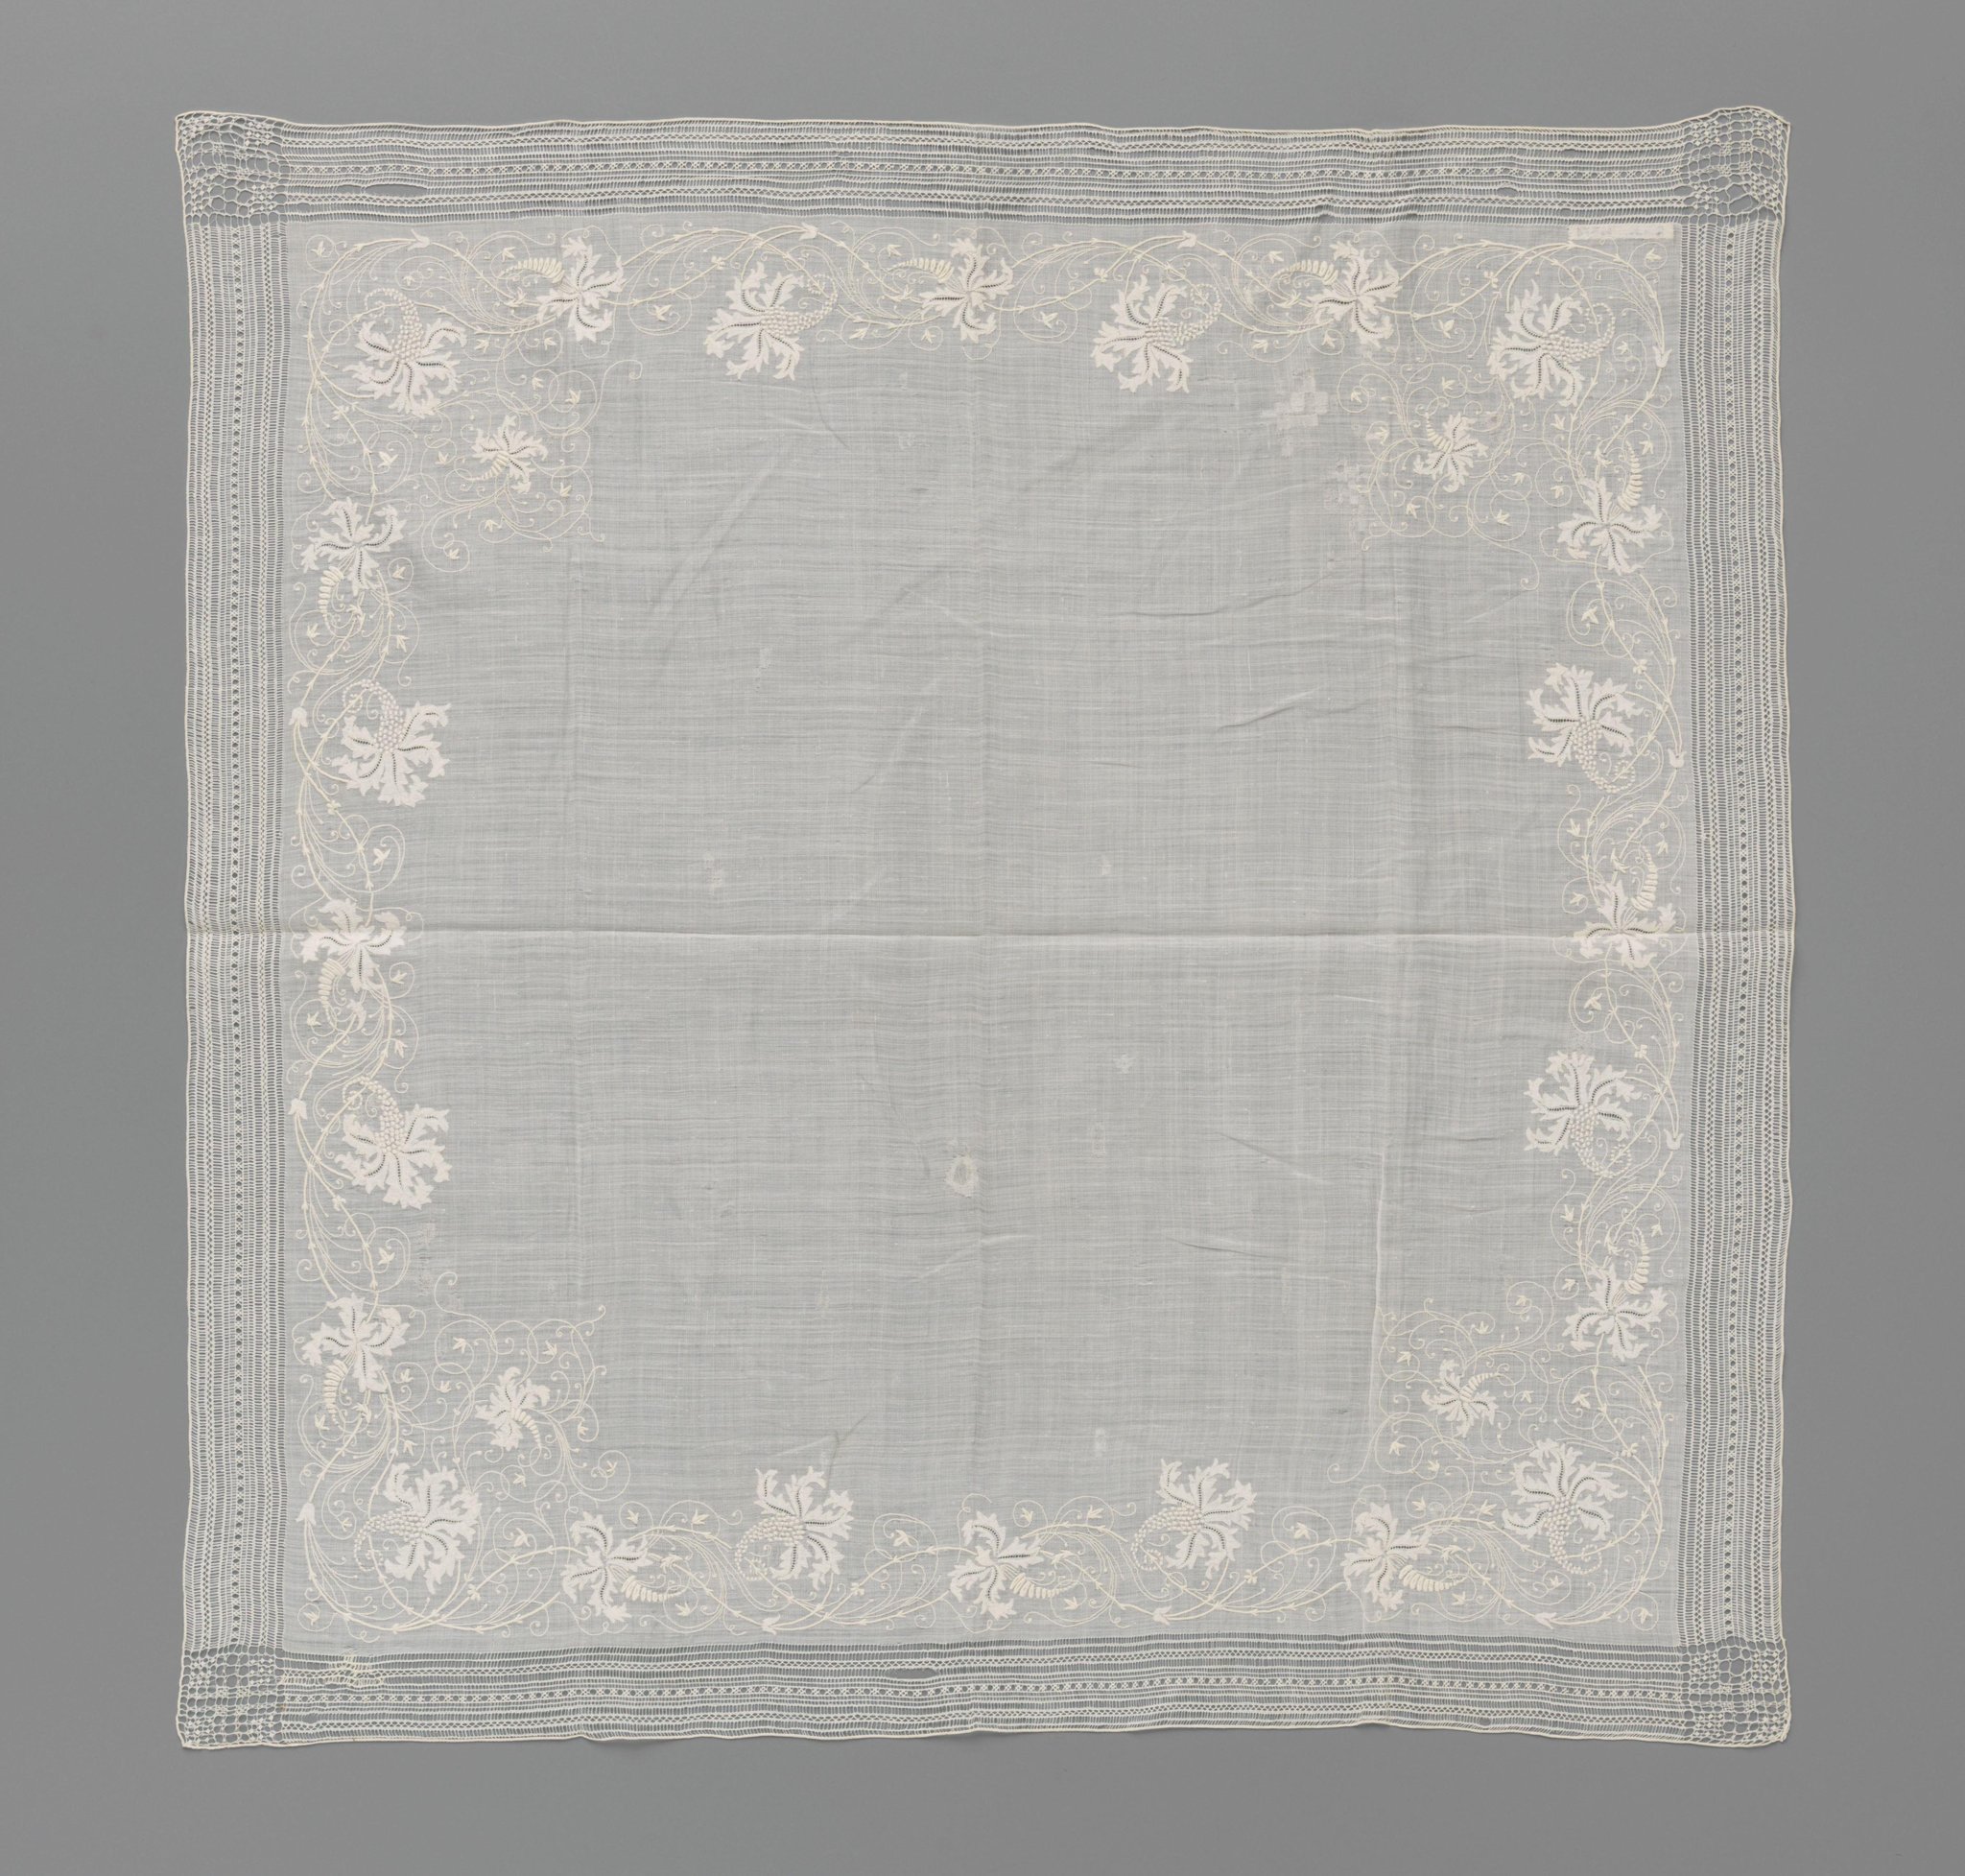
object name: handkerchief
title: Batisten zakdoek met borduurwerk en een rand fils tirés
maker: Anonymous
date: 1800-1849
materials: textile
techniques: embroidered, shadow quilted, weave, embroidery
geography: netherlands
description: Zakdoek van batist met borduurwerk waaronder plumetis en schaduwwerk en langs de zijkanten kantborduurwerk: werk met uitgetrokken draden. Vierkant model. Het borduurwerk heeft een patroon dat bestaat uit een sierlijk lijnenspel van golvende en omkrullende ijle ranken met vele omkrullende zijtakjes. Aan de ranken groeien grote exotische bloemen met grillige anjerachtige bloemblaadjes en per bloem steeds een ver uitstekende hoornvormige stamper. De spaarzaam geborduurde blaadjes aan de ranken zijn klein ten opzichte van de bloemen. Het werk met uitgetrokken draden heeft een patroon met verschillende lijnen en op de hoeken een patroon met kleine ruitjes in een vierkant rasterwerk.